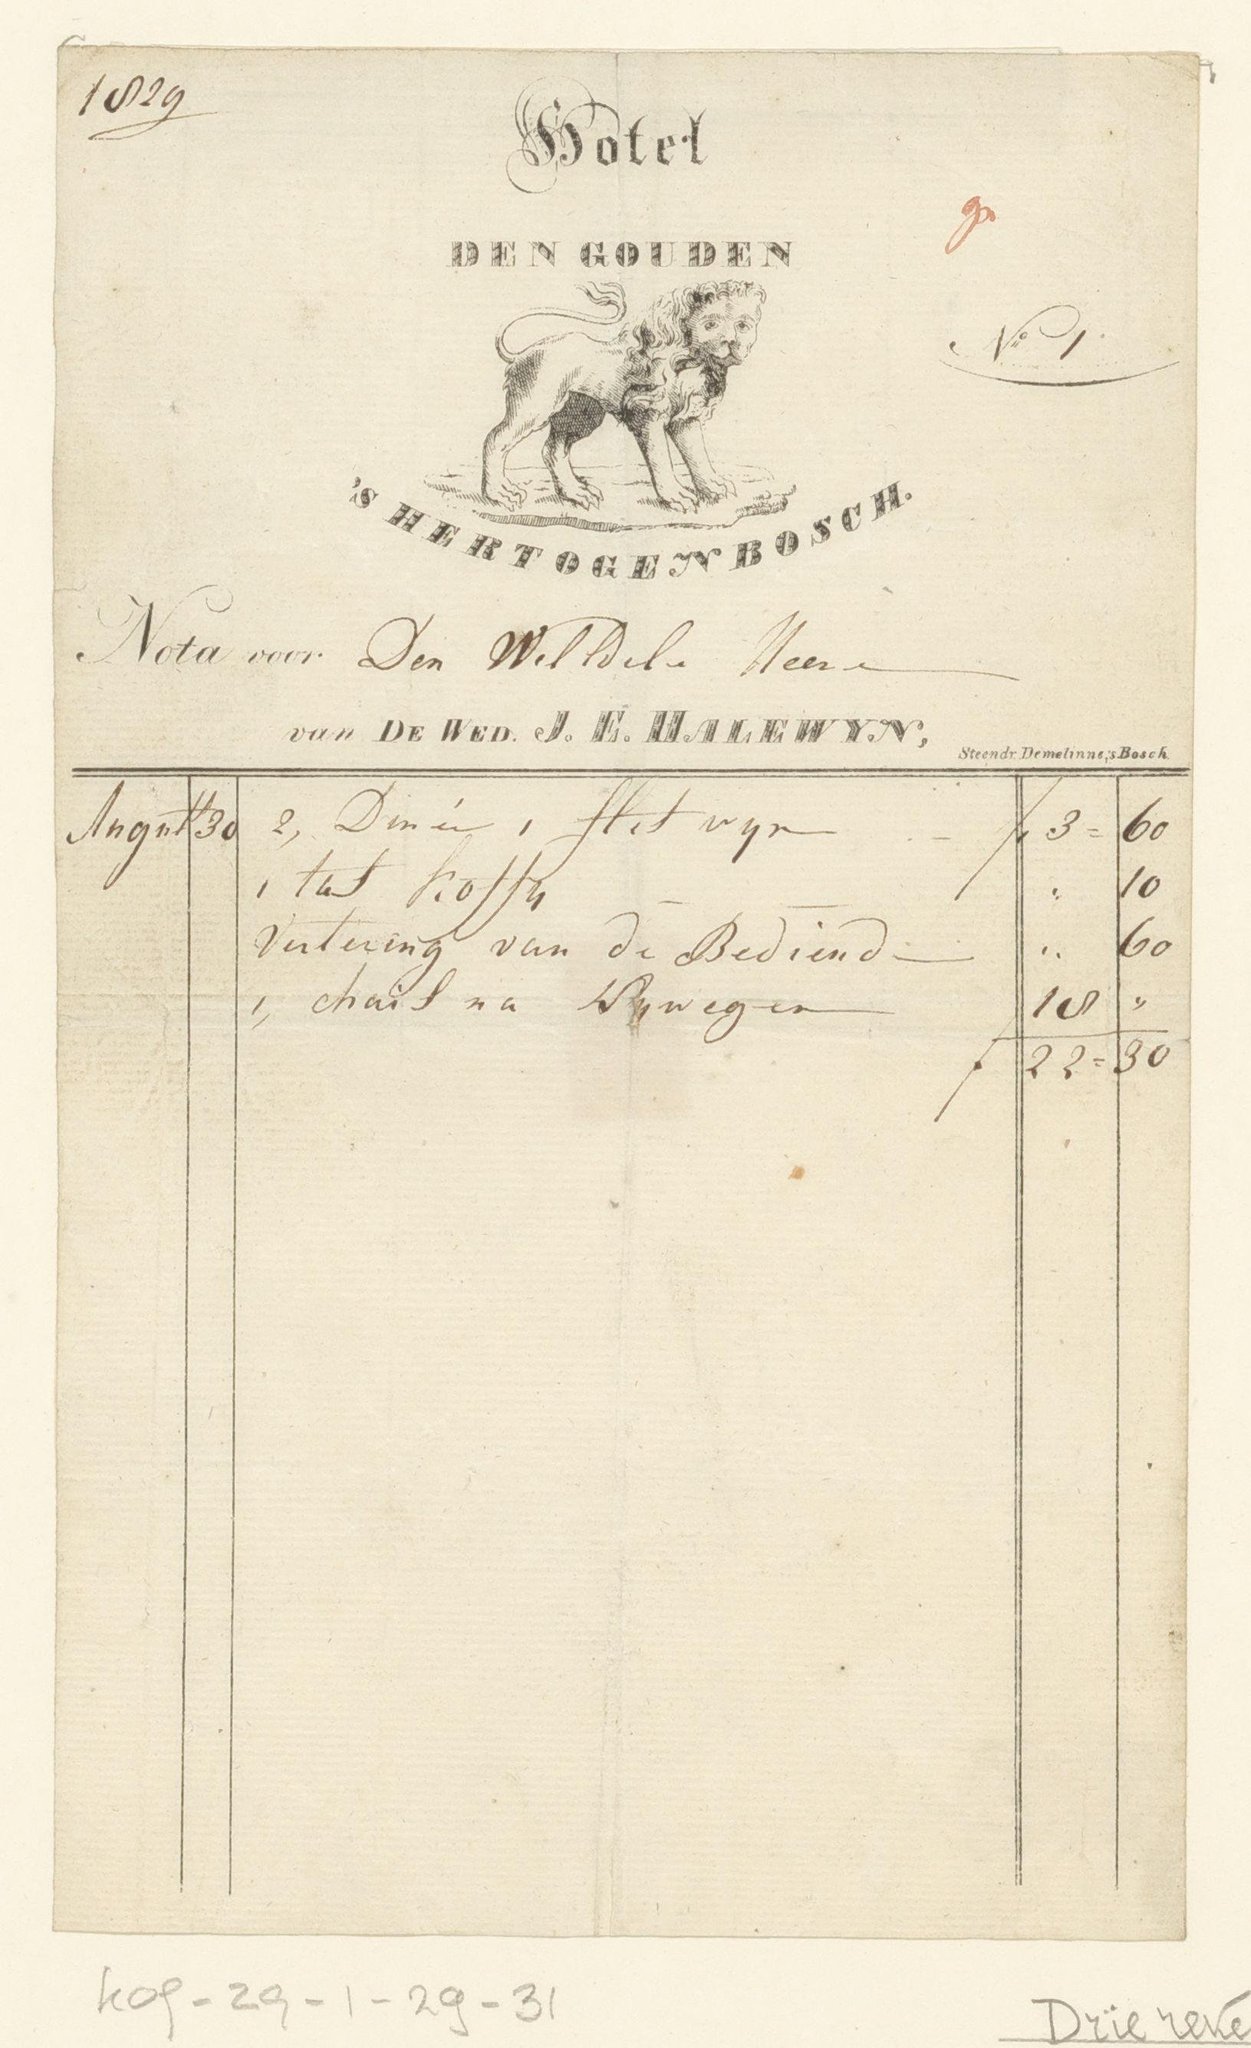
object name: print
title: Rekening voor het Hotel den Gouden Leeuw te 's-Hertogenbosch, 1829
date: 1829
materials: ink, paper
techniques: lithograph, pen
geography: den bosch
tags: beasts of prey, predatory animals: lion, hotel, hostelry, inn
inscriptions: collector's mark: Lugt 1641, stamp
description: Rekening voor het Hotel den Gouden Leeuw te 's-Hertogenbosch van de weduwe J. E. Halewijn. Op de rekening staat een diner en een fles wijn, een kop koffie kosten voor bedieningen en rit met de chais naar Nijmegen. Onderwerpsrubrieken binnen de Atlas Zeden en Gewoonten: Zeden en gewoonten in engeren zin, Volksleven, Uitspanningslokalen, Hotels.